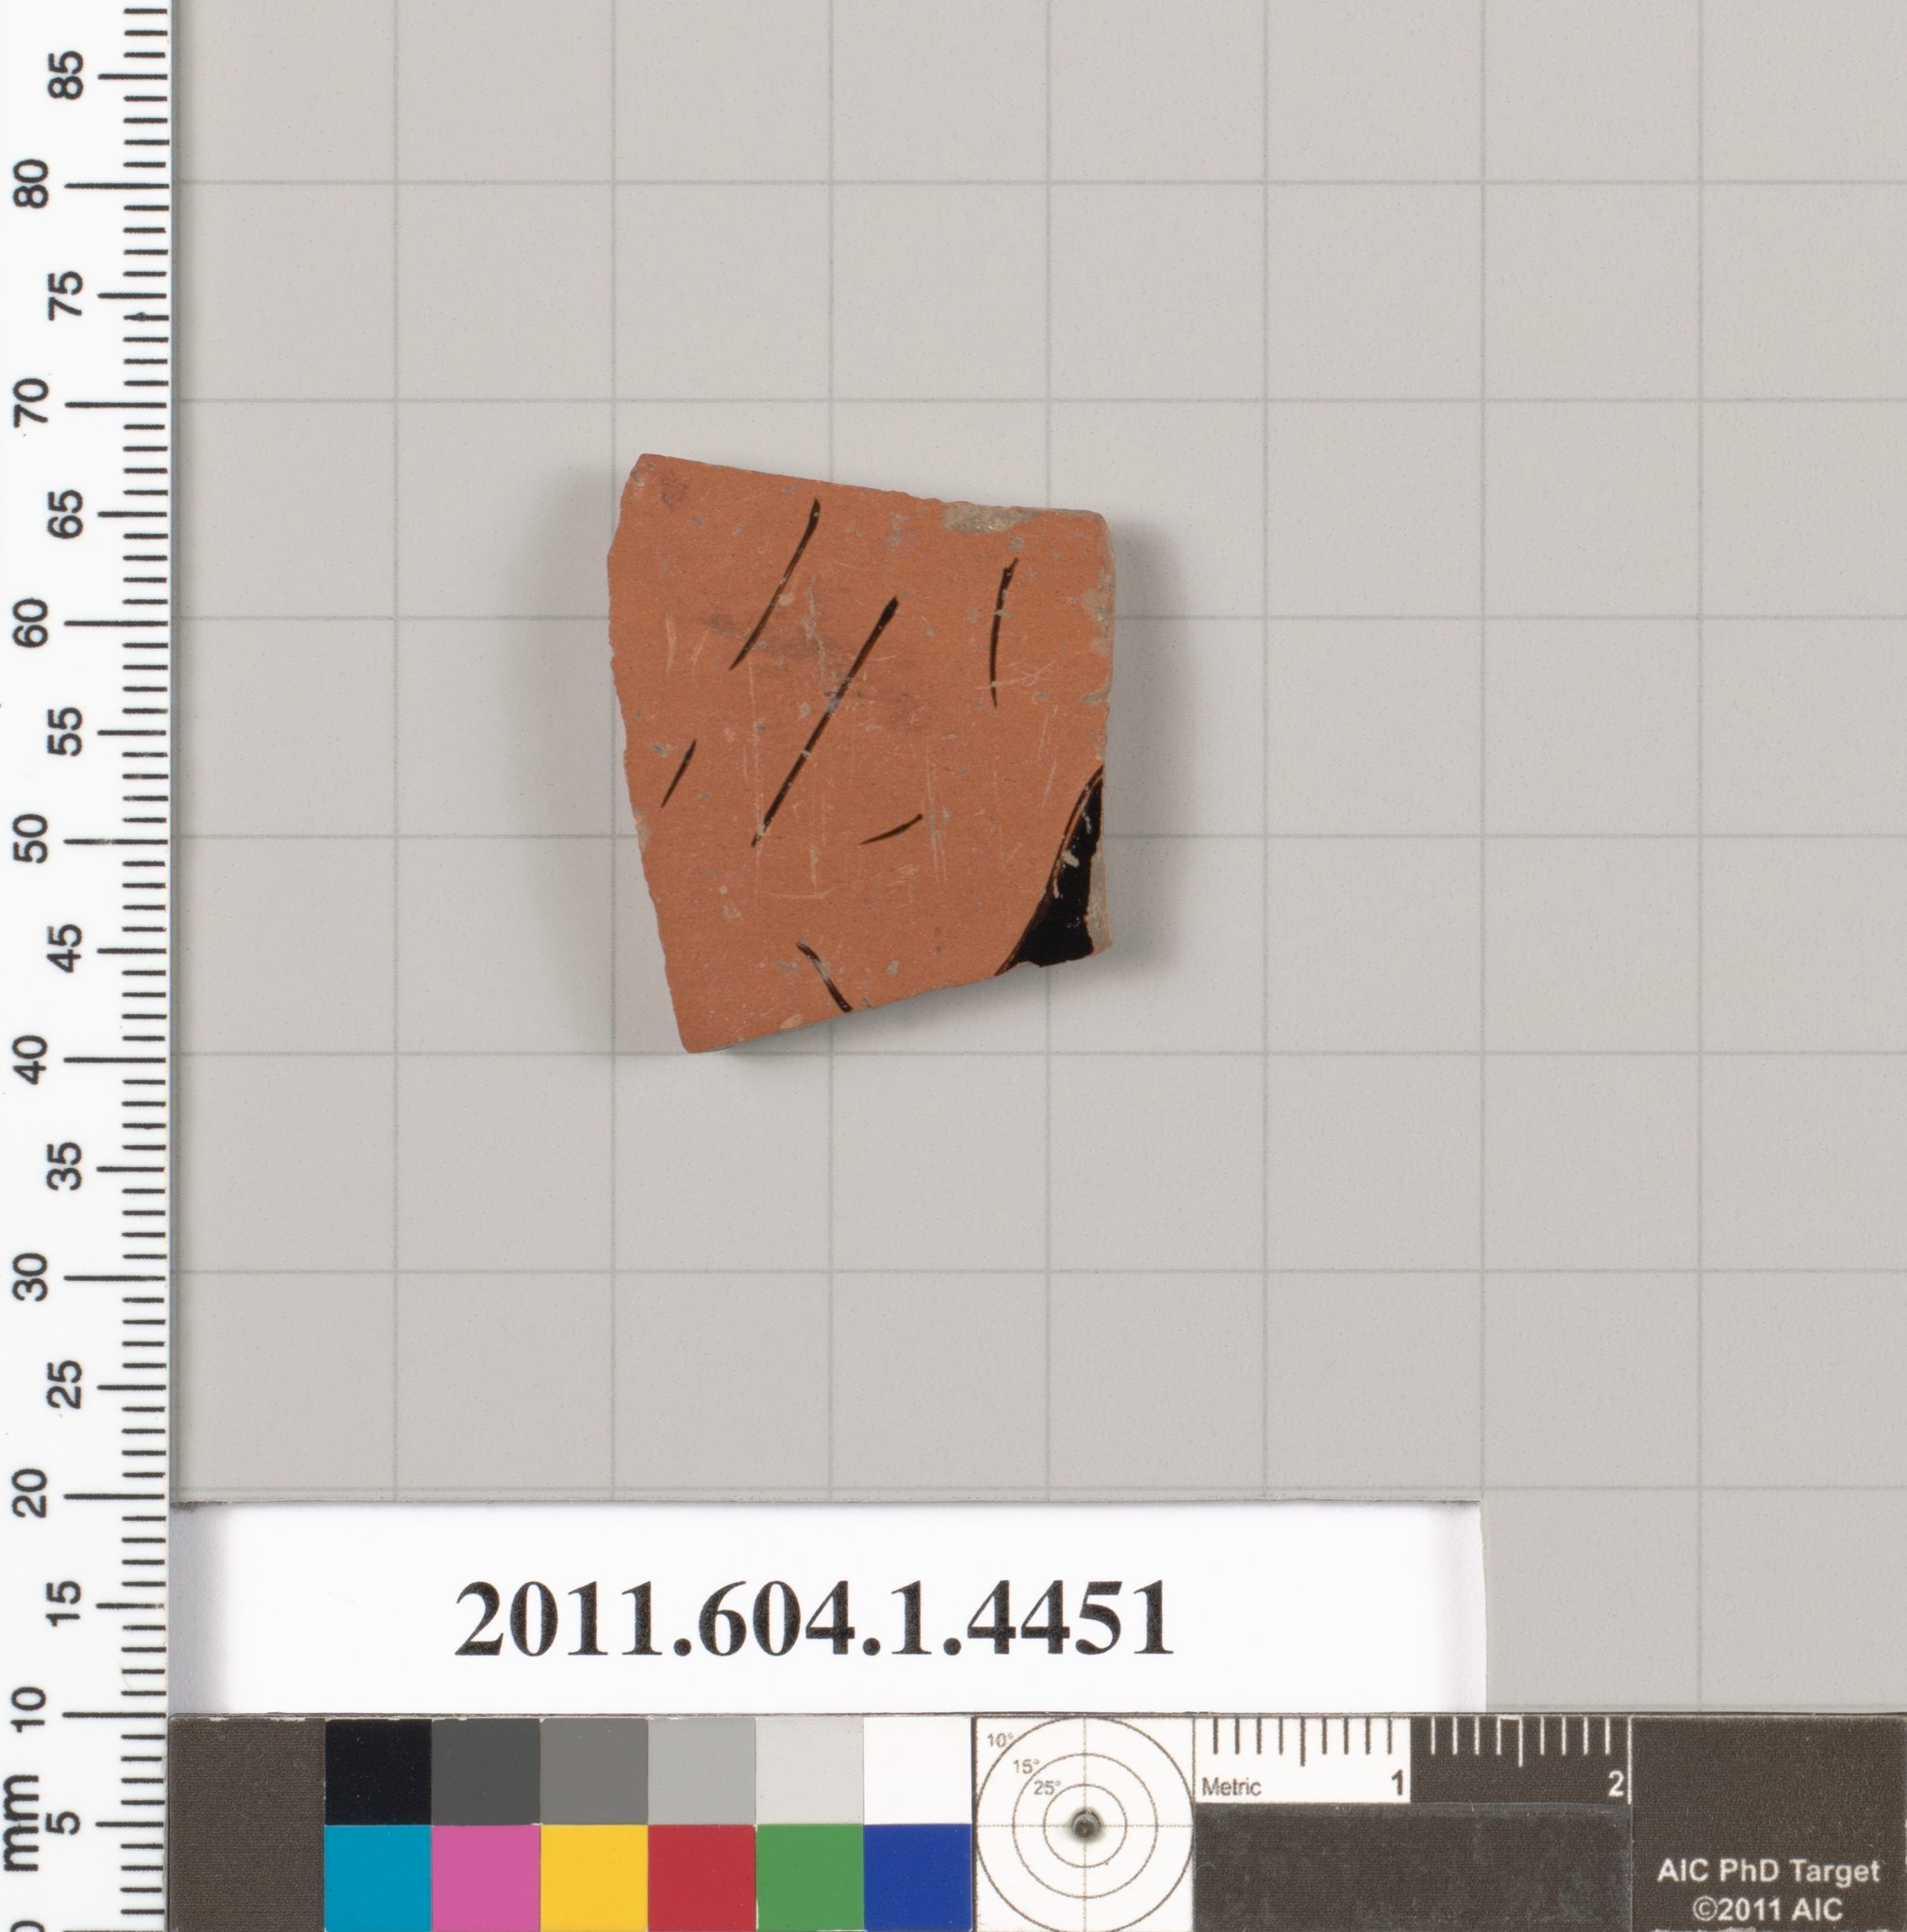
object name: kylix fragment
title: Terracotta fragment of a kylix (drinking cup)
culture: greek, attic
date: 475-451 BCE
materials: terracotta